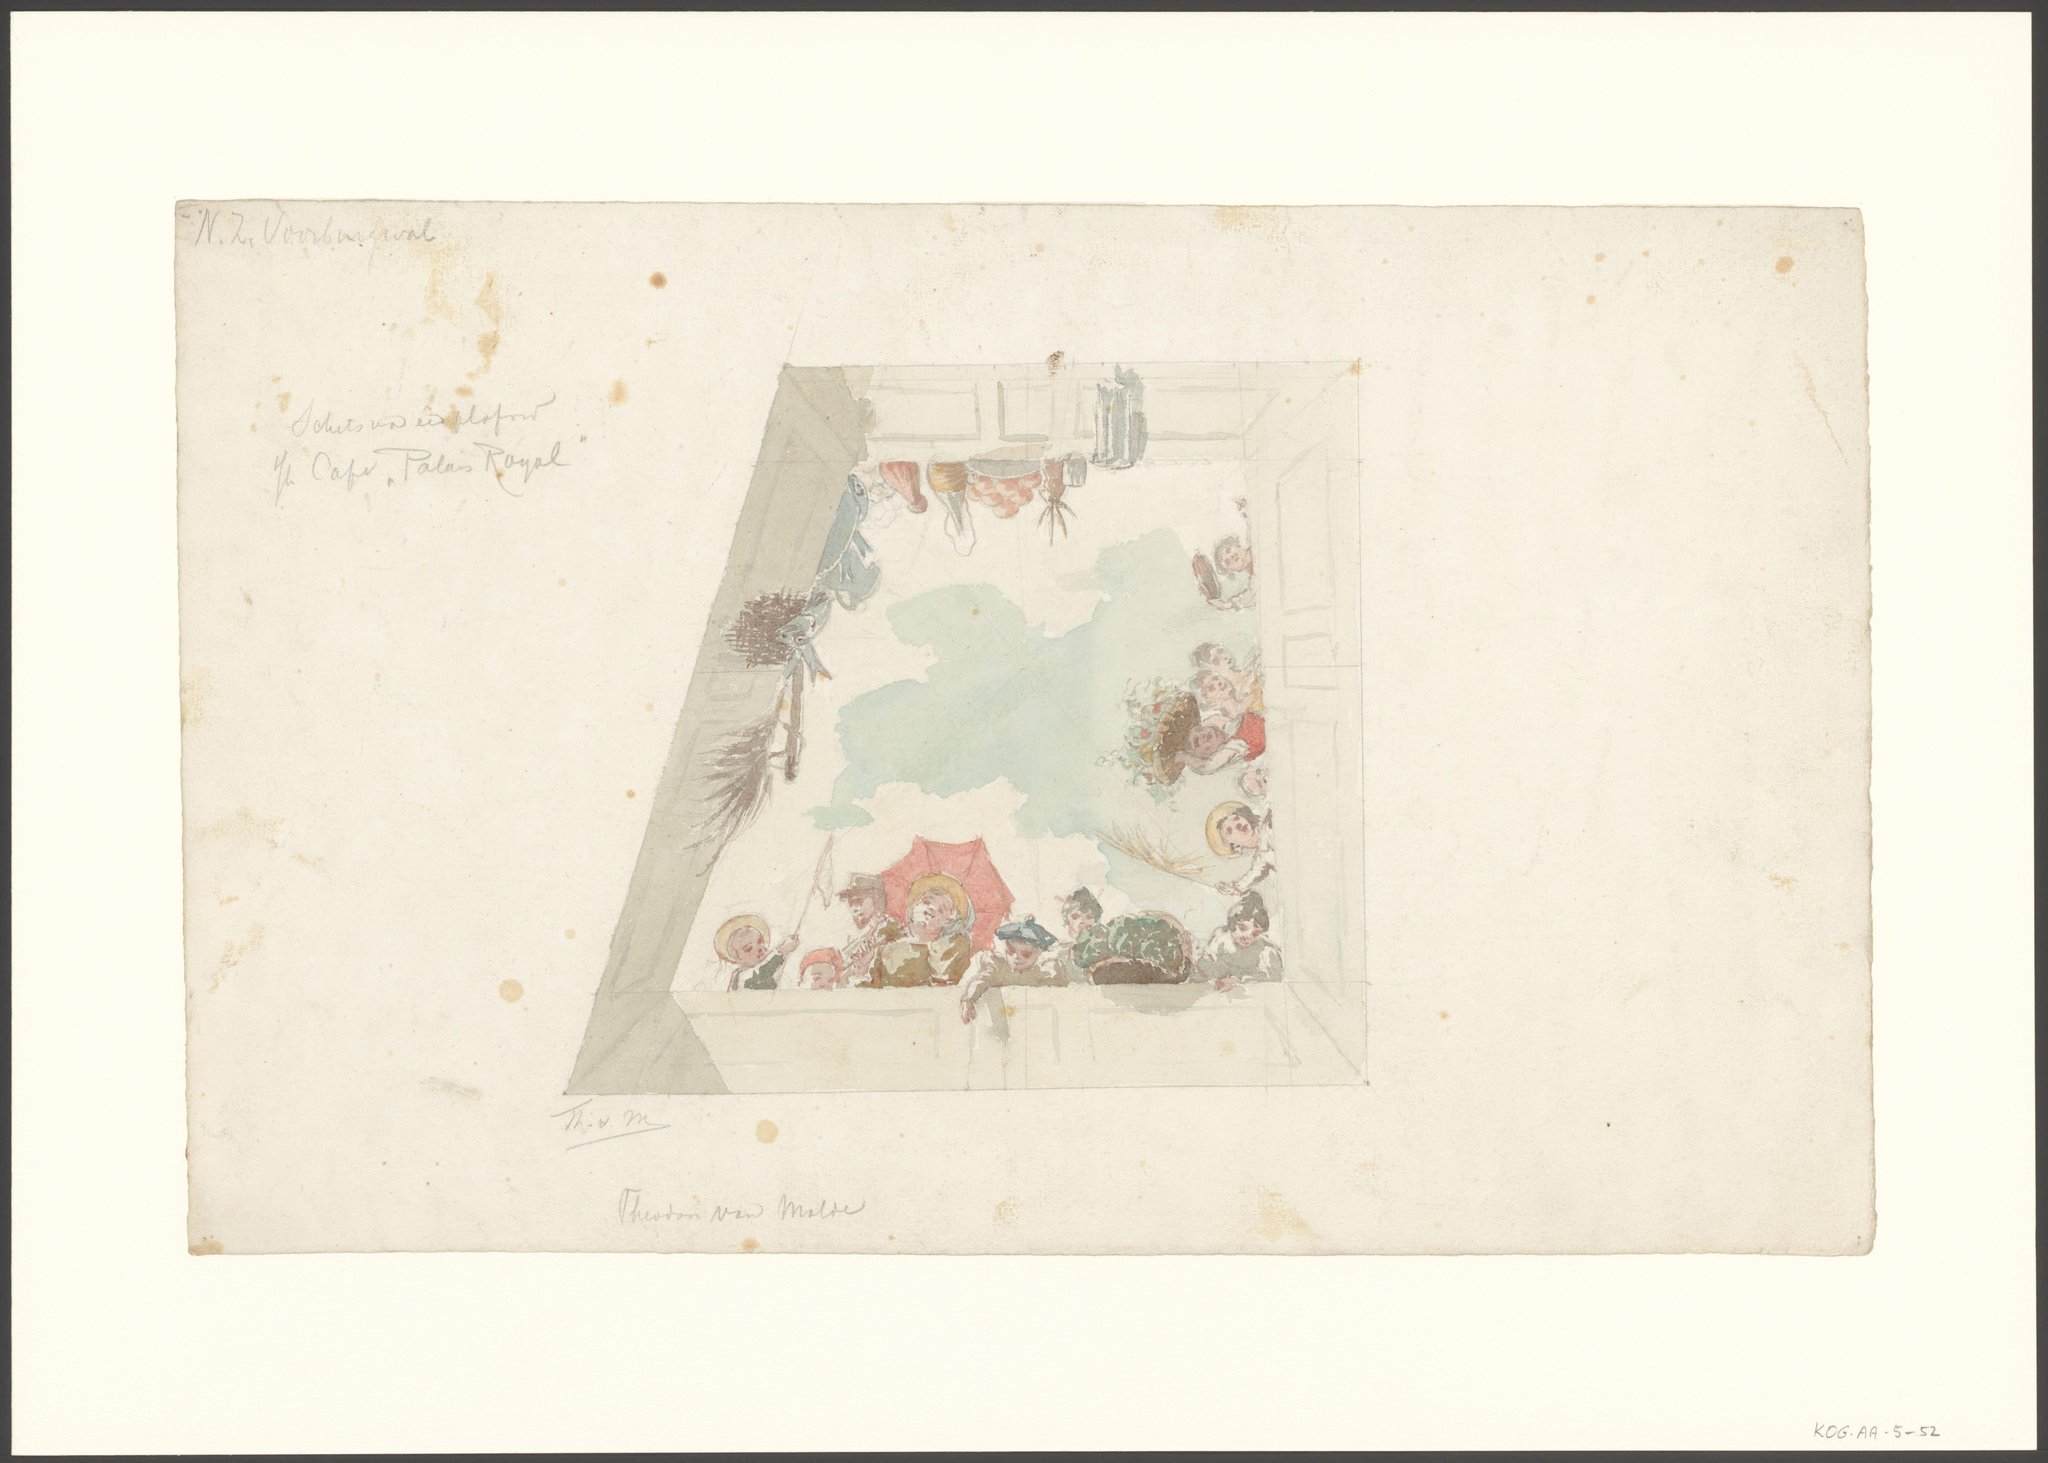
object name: design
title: Ontwerp voor het plafond in het café van Palais Royal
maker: Anonymous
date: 1877-1950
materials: paper, pencil, watercolor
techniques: brush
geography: amsterdam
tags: inn, coffee-house, public house, etc., (decorated) ceiling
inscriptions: number: ‘54’, inscription: ‘VDE 1.7.85’, name: ‘Th. v. M. / Theodoor van Malde’, inscription: ‘N.Z. Voorburgwal / Schets van een plafond / In Cafe "Palais Royal"’, number: ‘54’